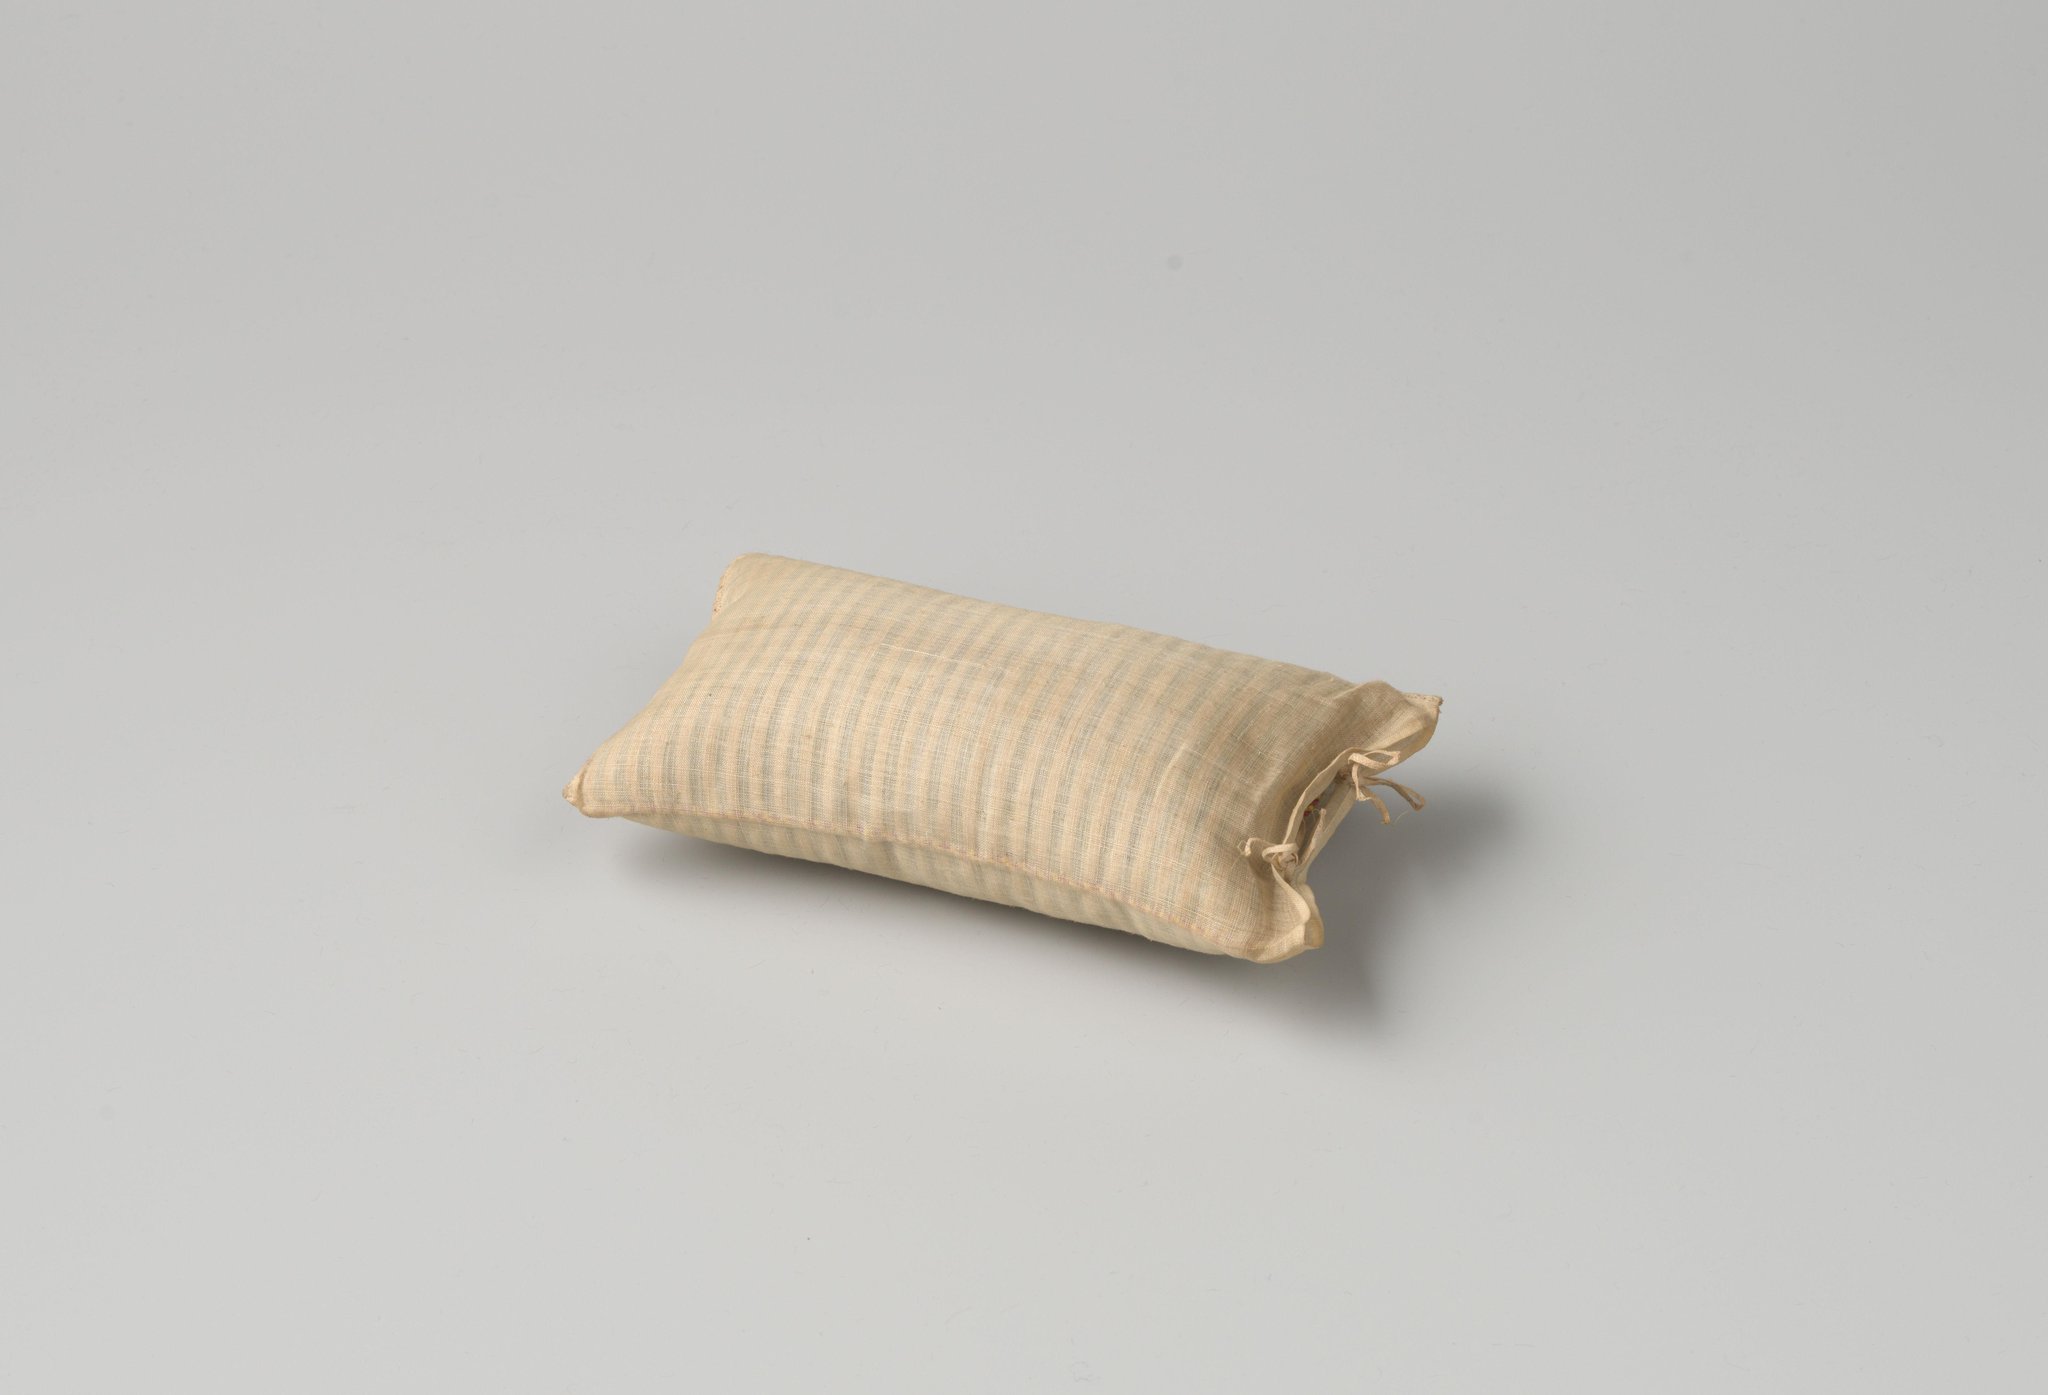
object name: bolster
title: Peluwkussen van blauw-wit gestreept linnen / katoen weefsel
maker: Anonymous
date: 1690-1710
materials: cotton, down, linen, silk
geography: amsterdam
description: Peluwkussen van blauw-wit gestreept linnen/katoen weefsel, omboord met gevlochten koordje van gele en rode zijde (als behangsel van het kraambed); gevuld met dons.